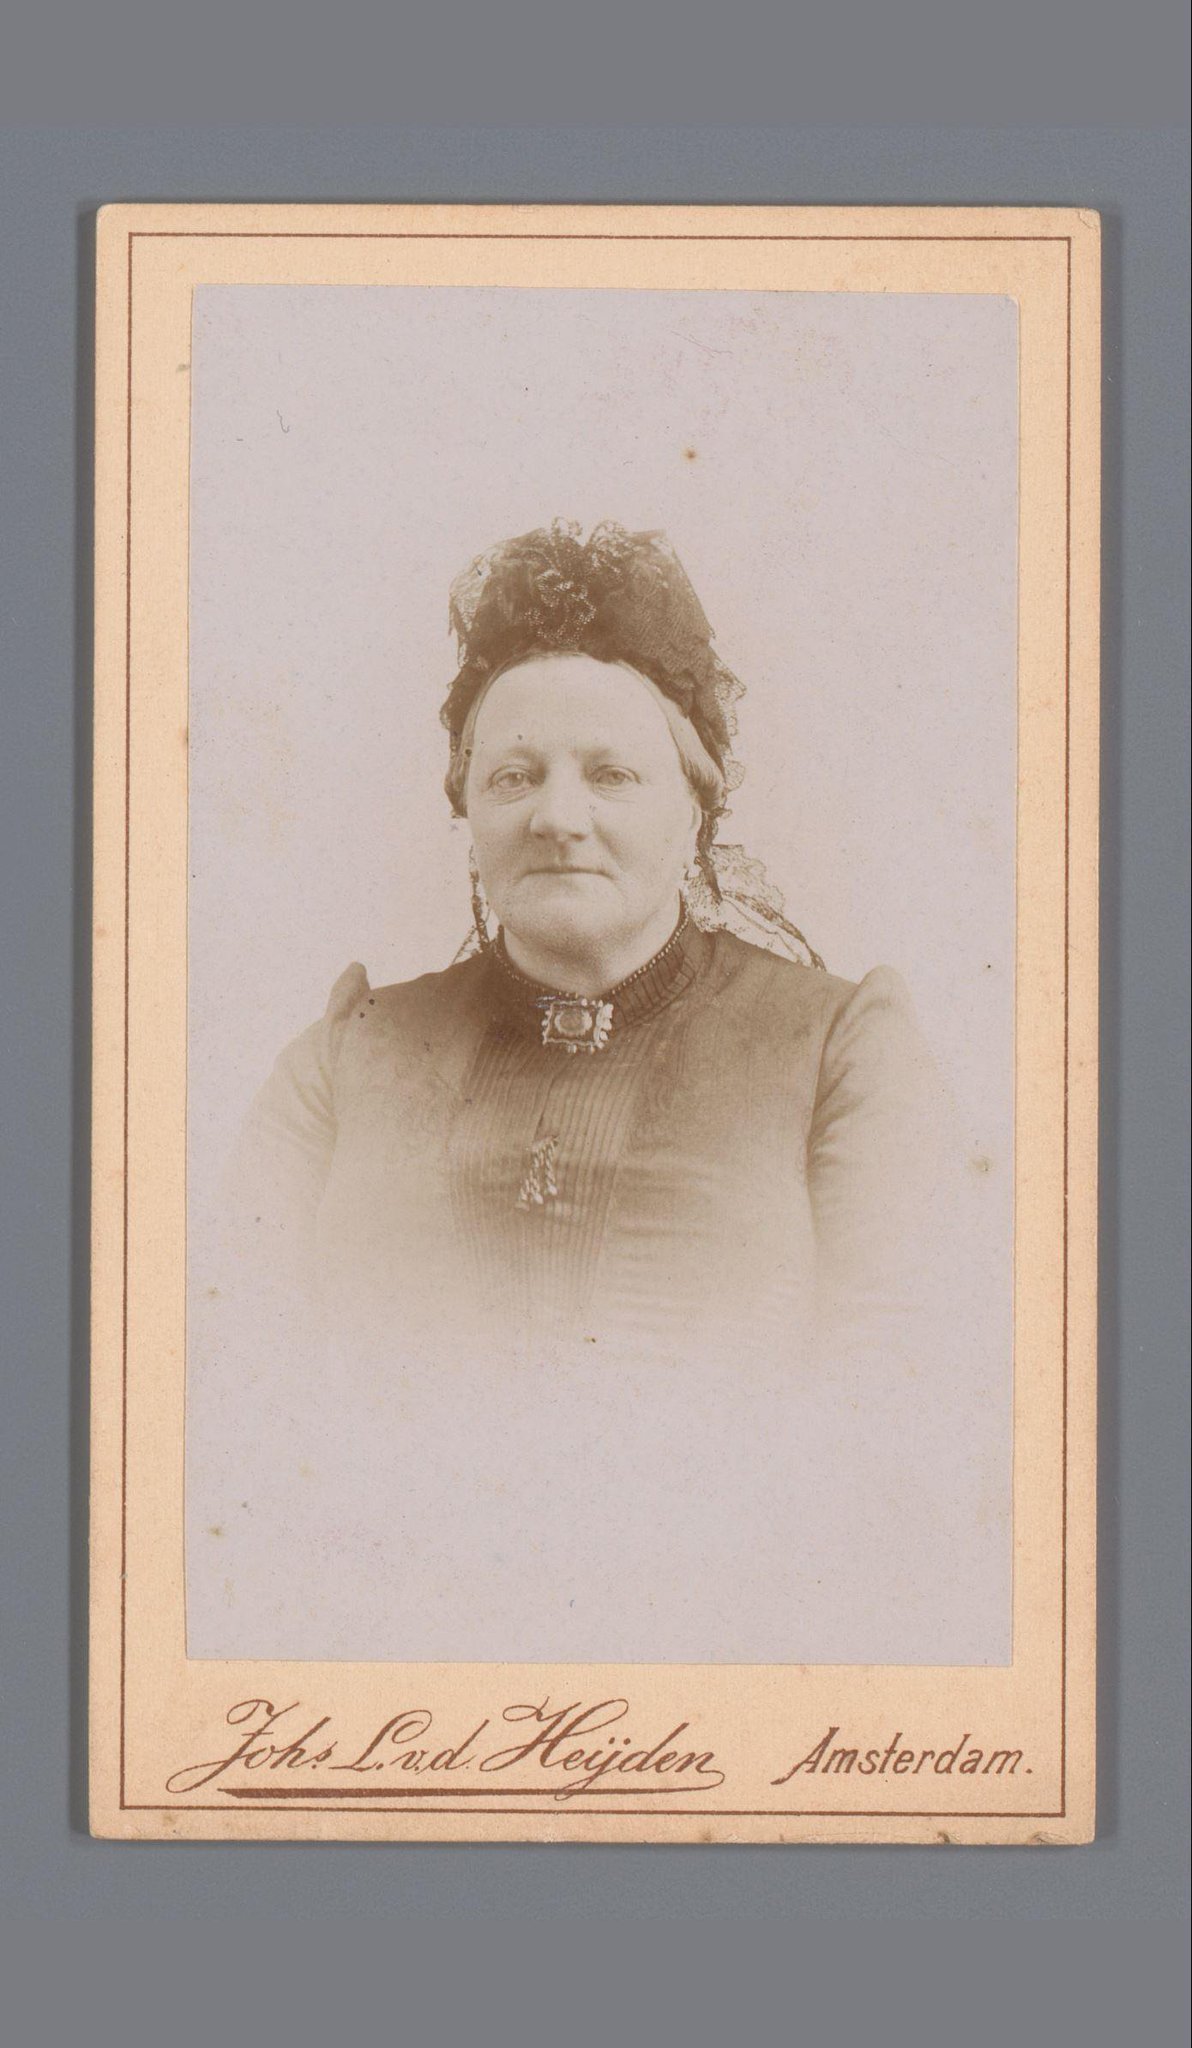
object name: photograph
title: Portret van een onbekende vrouw met een muts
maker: johannes leonardus van der heijden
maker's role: fotograaf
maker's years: 1856-1937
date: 1880-1915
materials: cardboard, photographic support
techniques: collodion silver print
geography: amsterdam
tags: historical persons - bb - woman, head-gear: cap, folk costume, regional costume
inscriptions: inscription: ‘Johs L. van der Heijden/ AMSTERDAM./ Sophiaplein, hoek Kalverstraat (Munt.)’